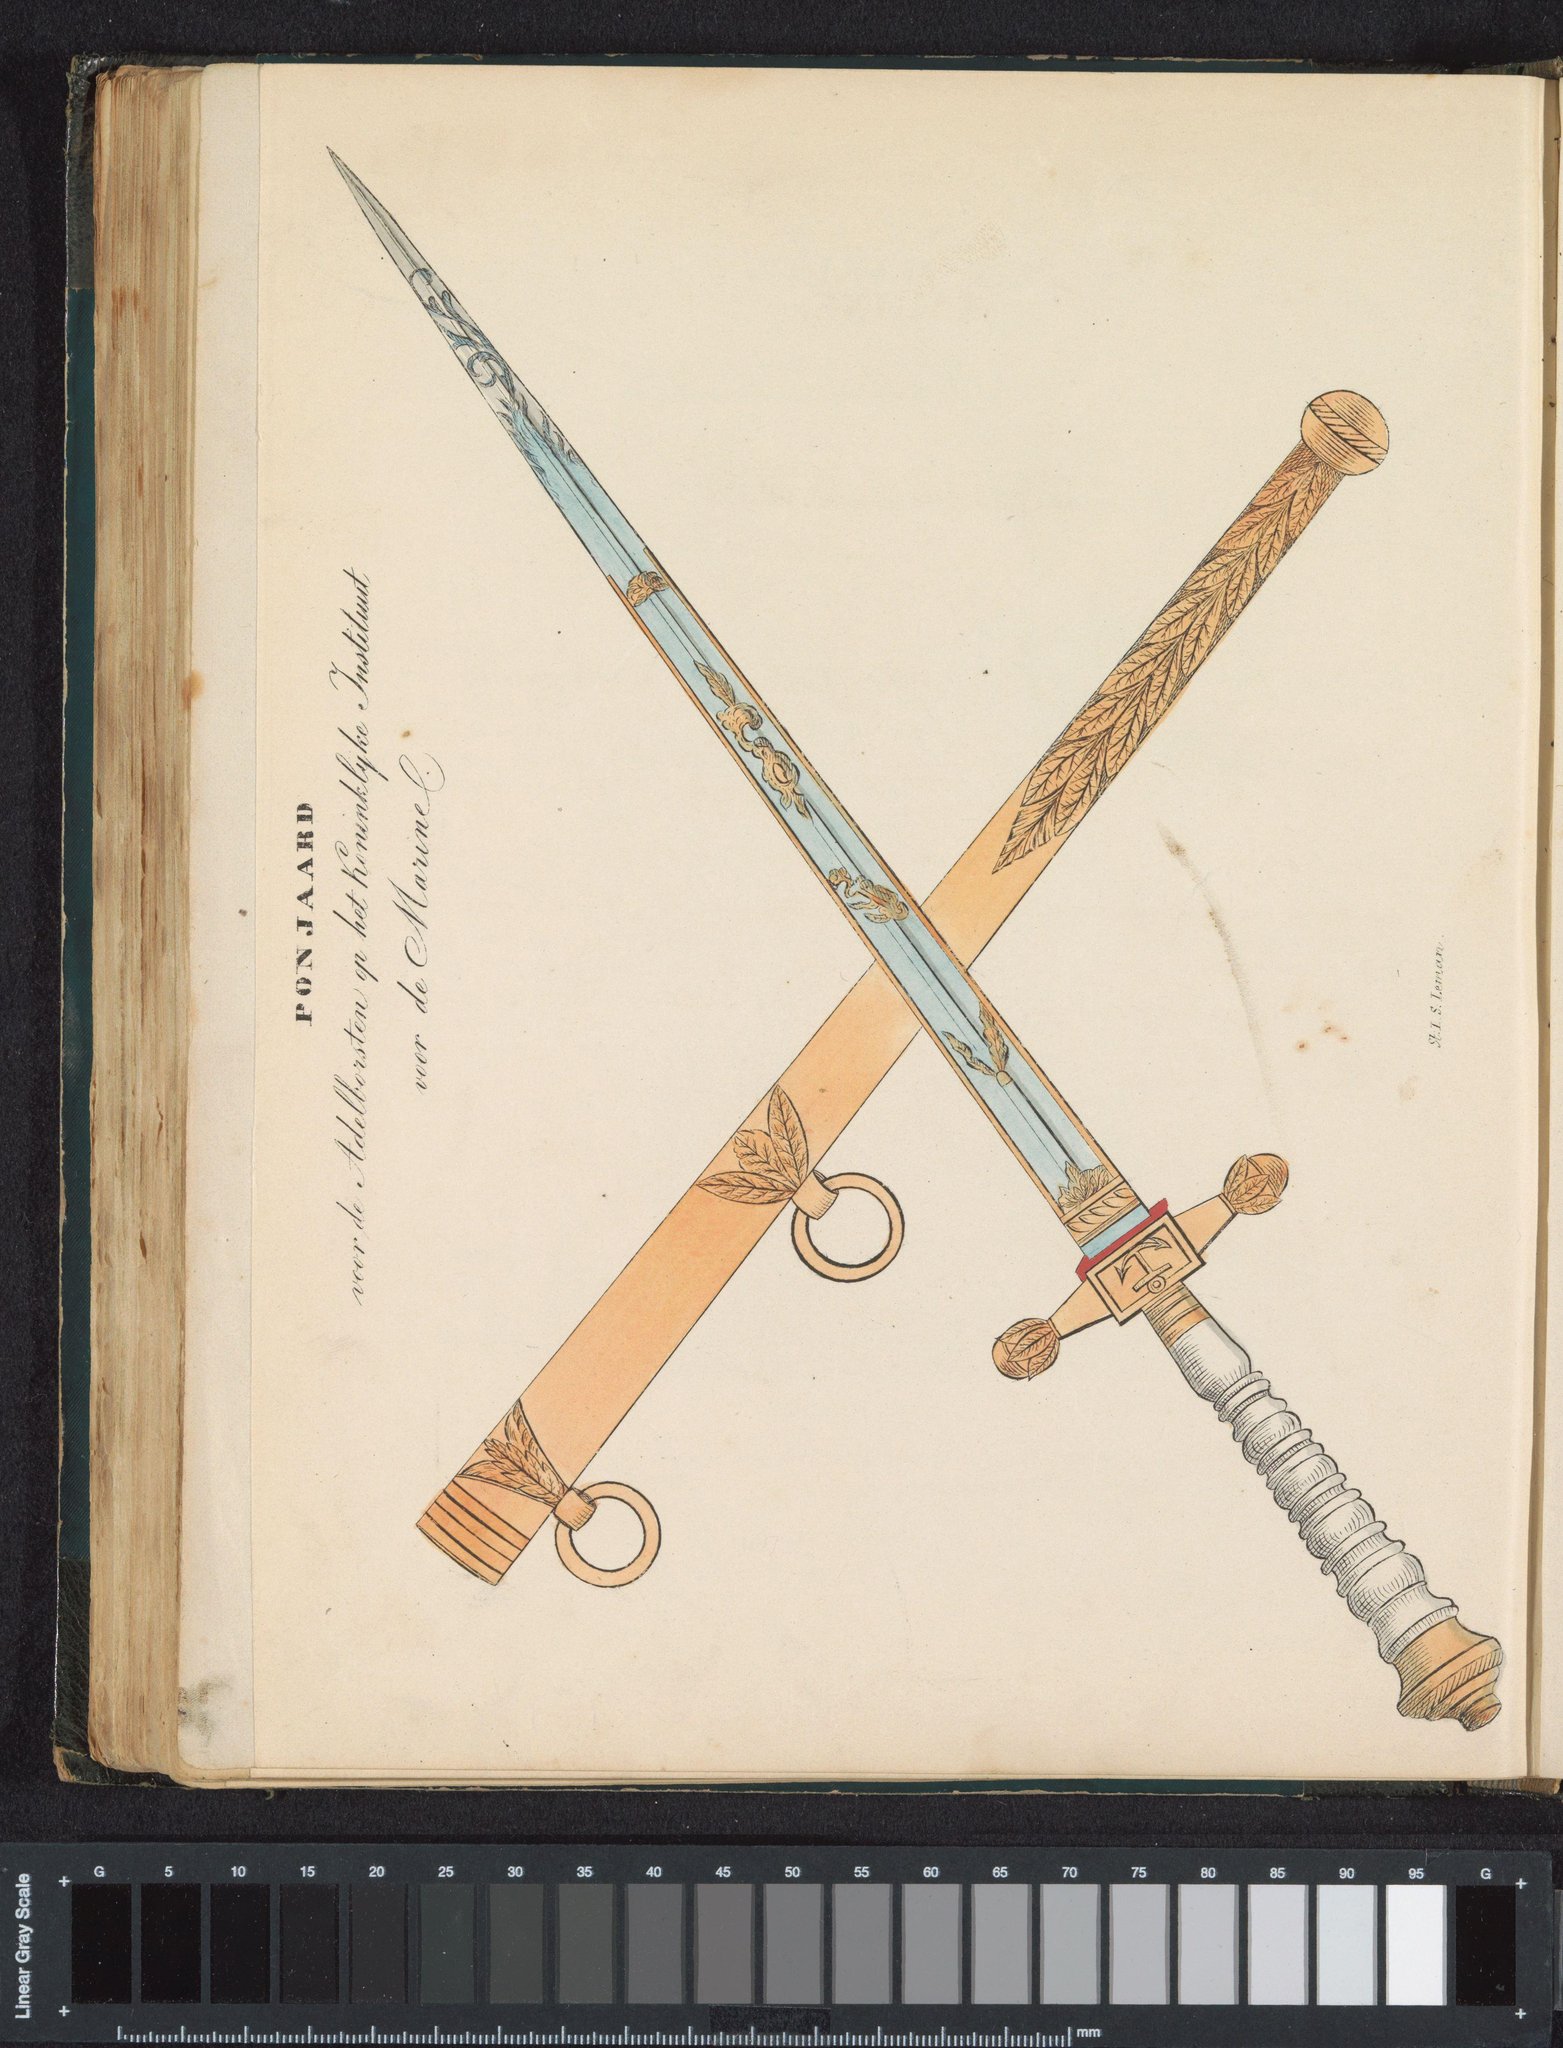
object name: book illustration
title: Ponjaard voor de Adelborsten op het Koninklijke Instituut voor de Marine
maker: louis salomon leman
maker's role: steendrukker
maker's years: 1818-1889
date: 1845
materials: paper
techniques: hand coloring, lithograph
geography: amsterdam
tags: hacking and thrusting weapons, (military) uniforms, netherlands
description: Ponjaard voor adelborsten op het Koninklijk Instituut voor de Marine. Illustratie in een boek uit 1845 over de uniformen en kledingstukken van de Nederlandse land-, zeemacht en schutterijen in Nederland en in de overzeese gebiedsdelen.